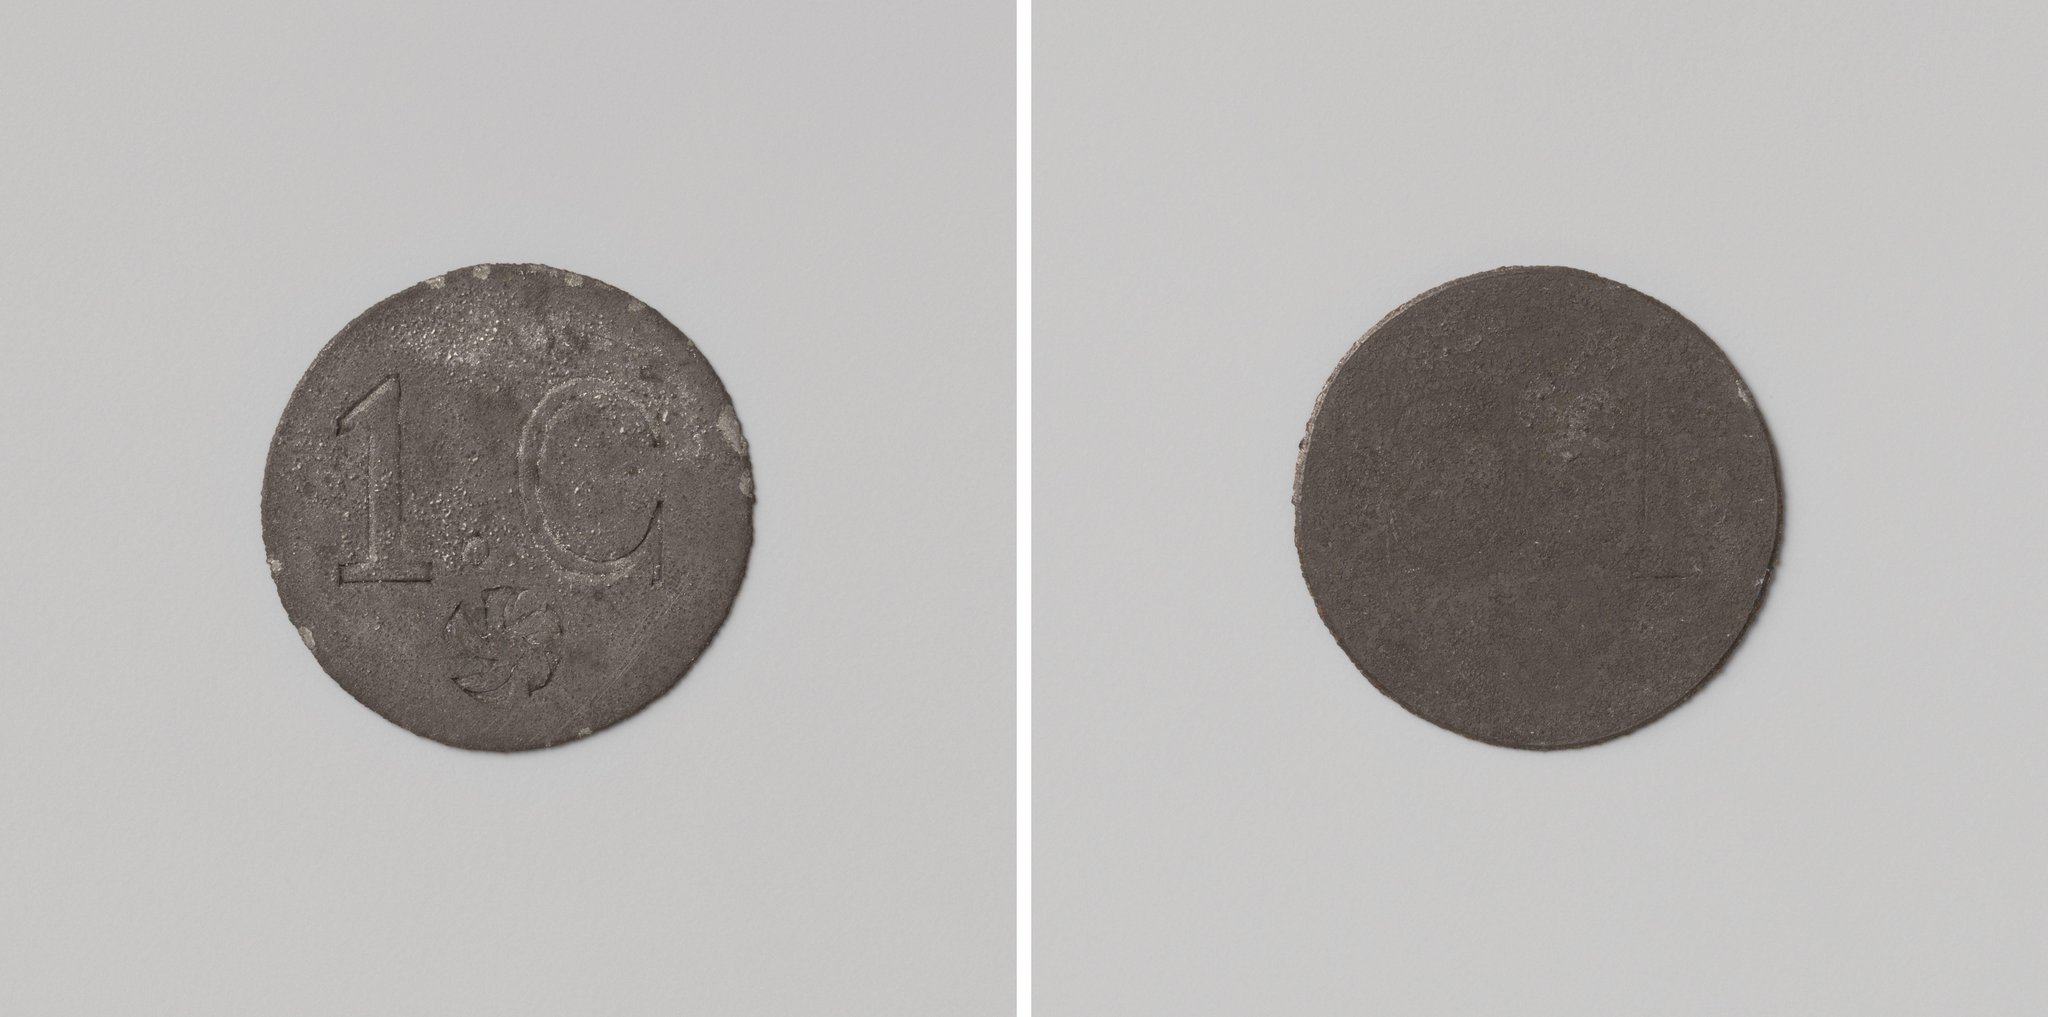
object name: cent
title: Strafgevangenis te 's-Hertogenbosch, huismunt ter waarde van eencent. In de periode 1824-1830 in 's-Hertogenbosch gebruikt, daarna in de periode 1831-1834 in Gouda en Woerden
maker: hendrikus wansink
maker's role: blikslager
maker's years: 1778-1869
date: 1824-1834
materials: metal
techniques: striking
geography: den bosch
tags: den bosch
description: enkelzijdige betaapenning. Voorzijde: waardeaanduiding boven vijfbladige rozet. Keerzijde: blanco